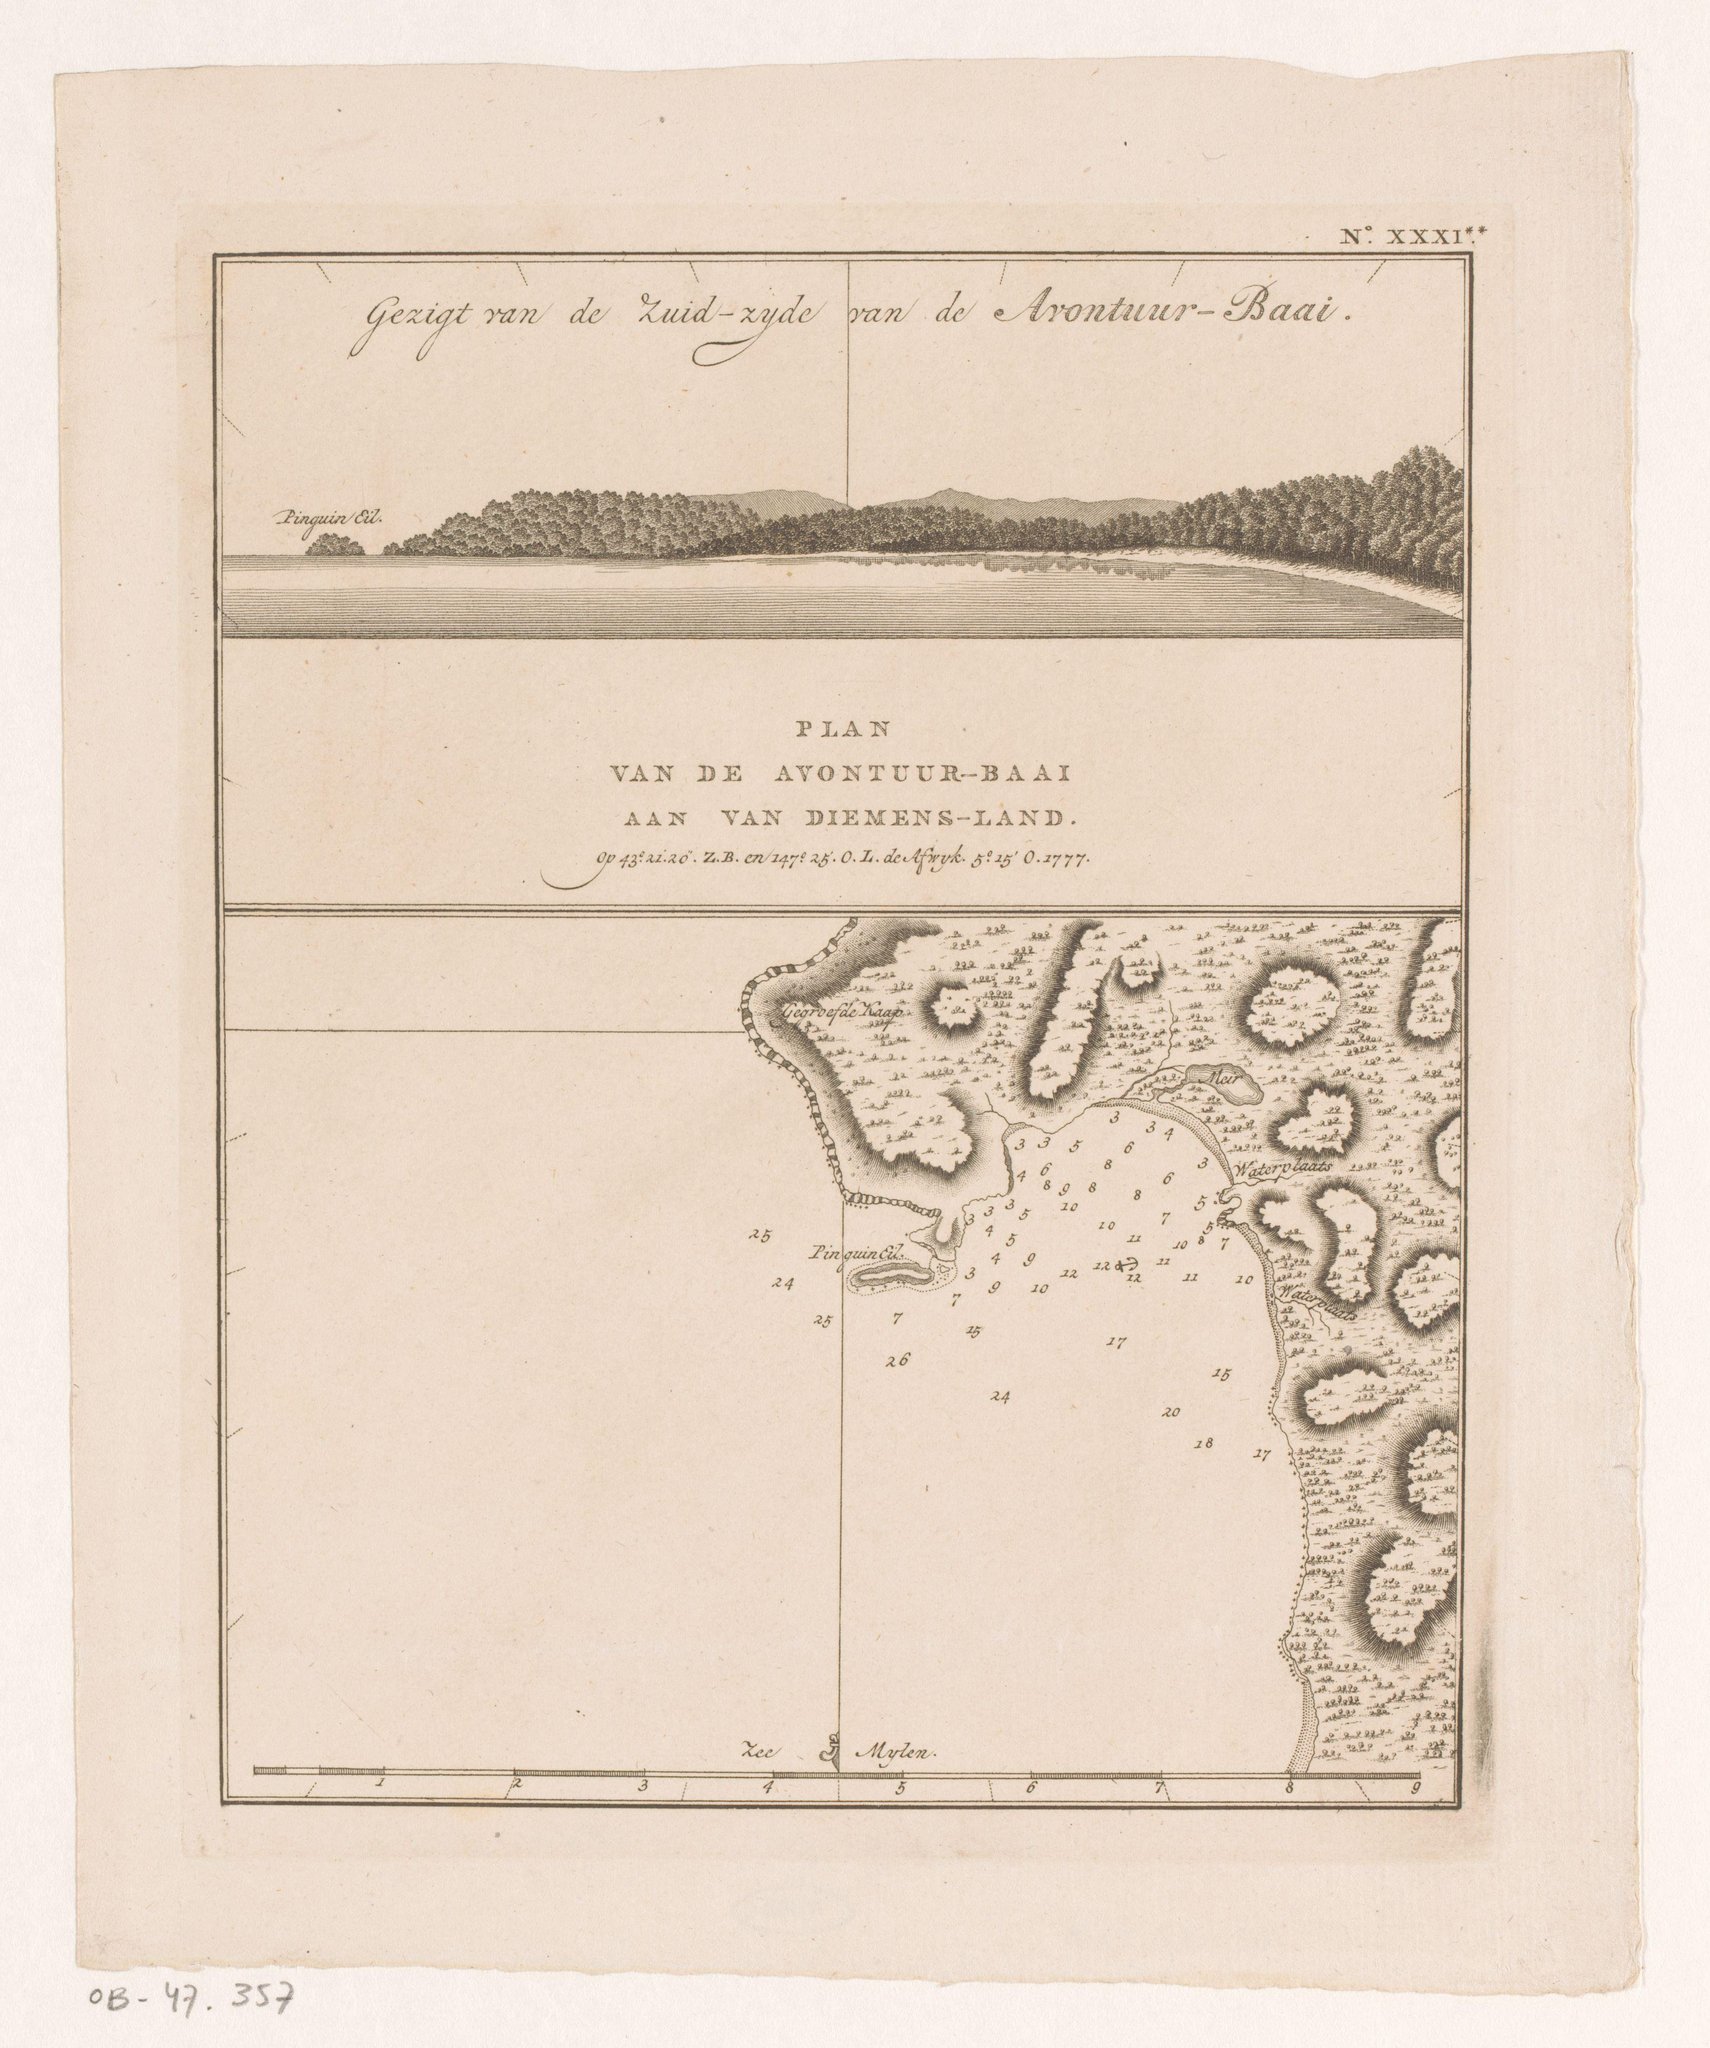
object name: map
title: Gezigt van de Zuid-zijde van de Avontuur-Baai. Plan van de Avontuur-baai aan Van Diemensland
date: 1801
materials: paper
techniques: etching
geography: leiden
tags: maps, atlases, coast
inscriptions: collector's mark: Lugt 2228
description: Prent uit: Cook, James. Reize rondom de Waereld (...) met kaarten en plaaten. [Vertaald uit het Engels door] Jan David Pasteur. Leiden: Honkoop, Amsterdam: Allart, Den Haag: Van Cleef, 1801, dl. 8, p. 181.